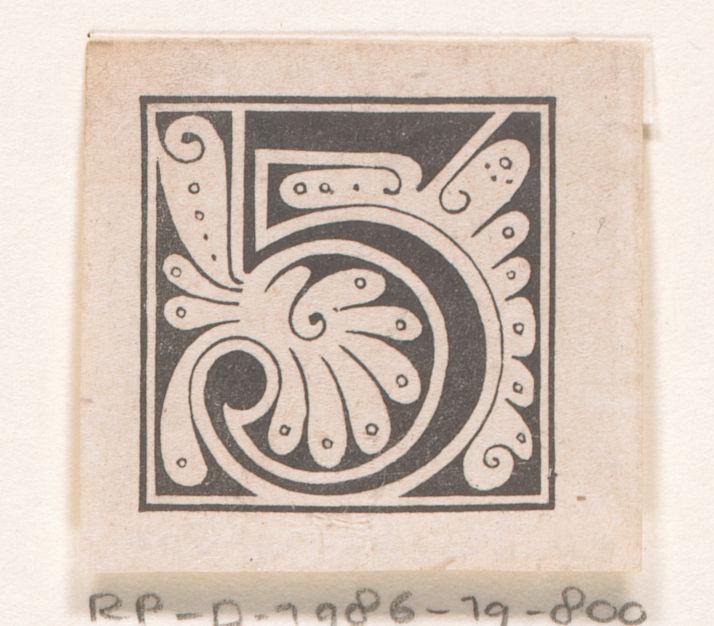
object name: photomechanical print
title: Getal 5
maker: reinier willem petrus de vries (1874-1953)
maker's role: draughtsman, print maker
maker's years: 1874-1953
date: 1904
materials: paper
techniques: printing block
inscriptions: collector's mark: ‘R:MVS.’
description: Het getal is gebruikt voor: Veth, Jan. Jozef Israëls en zijn kunst. Arnhem en Nijmegen: Gebroeders E&M Cohen, 1904.